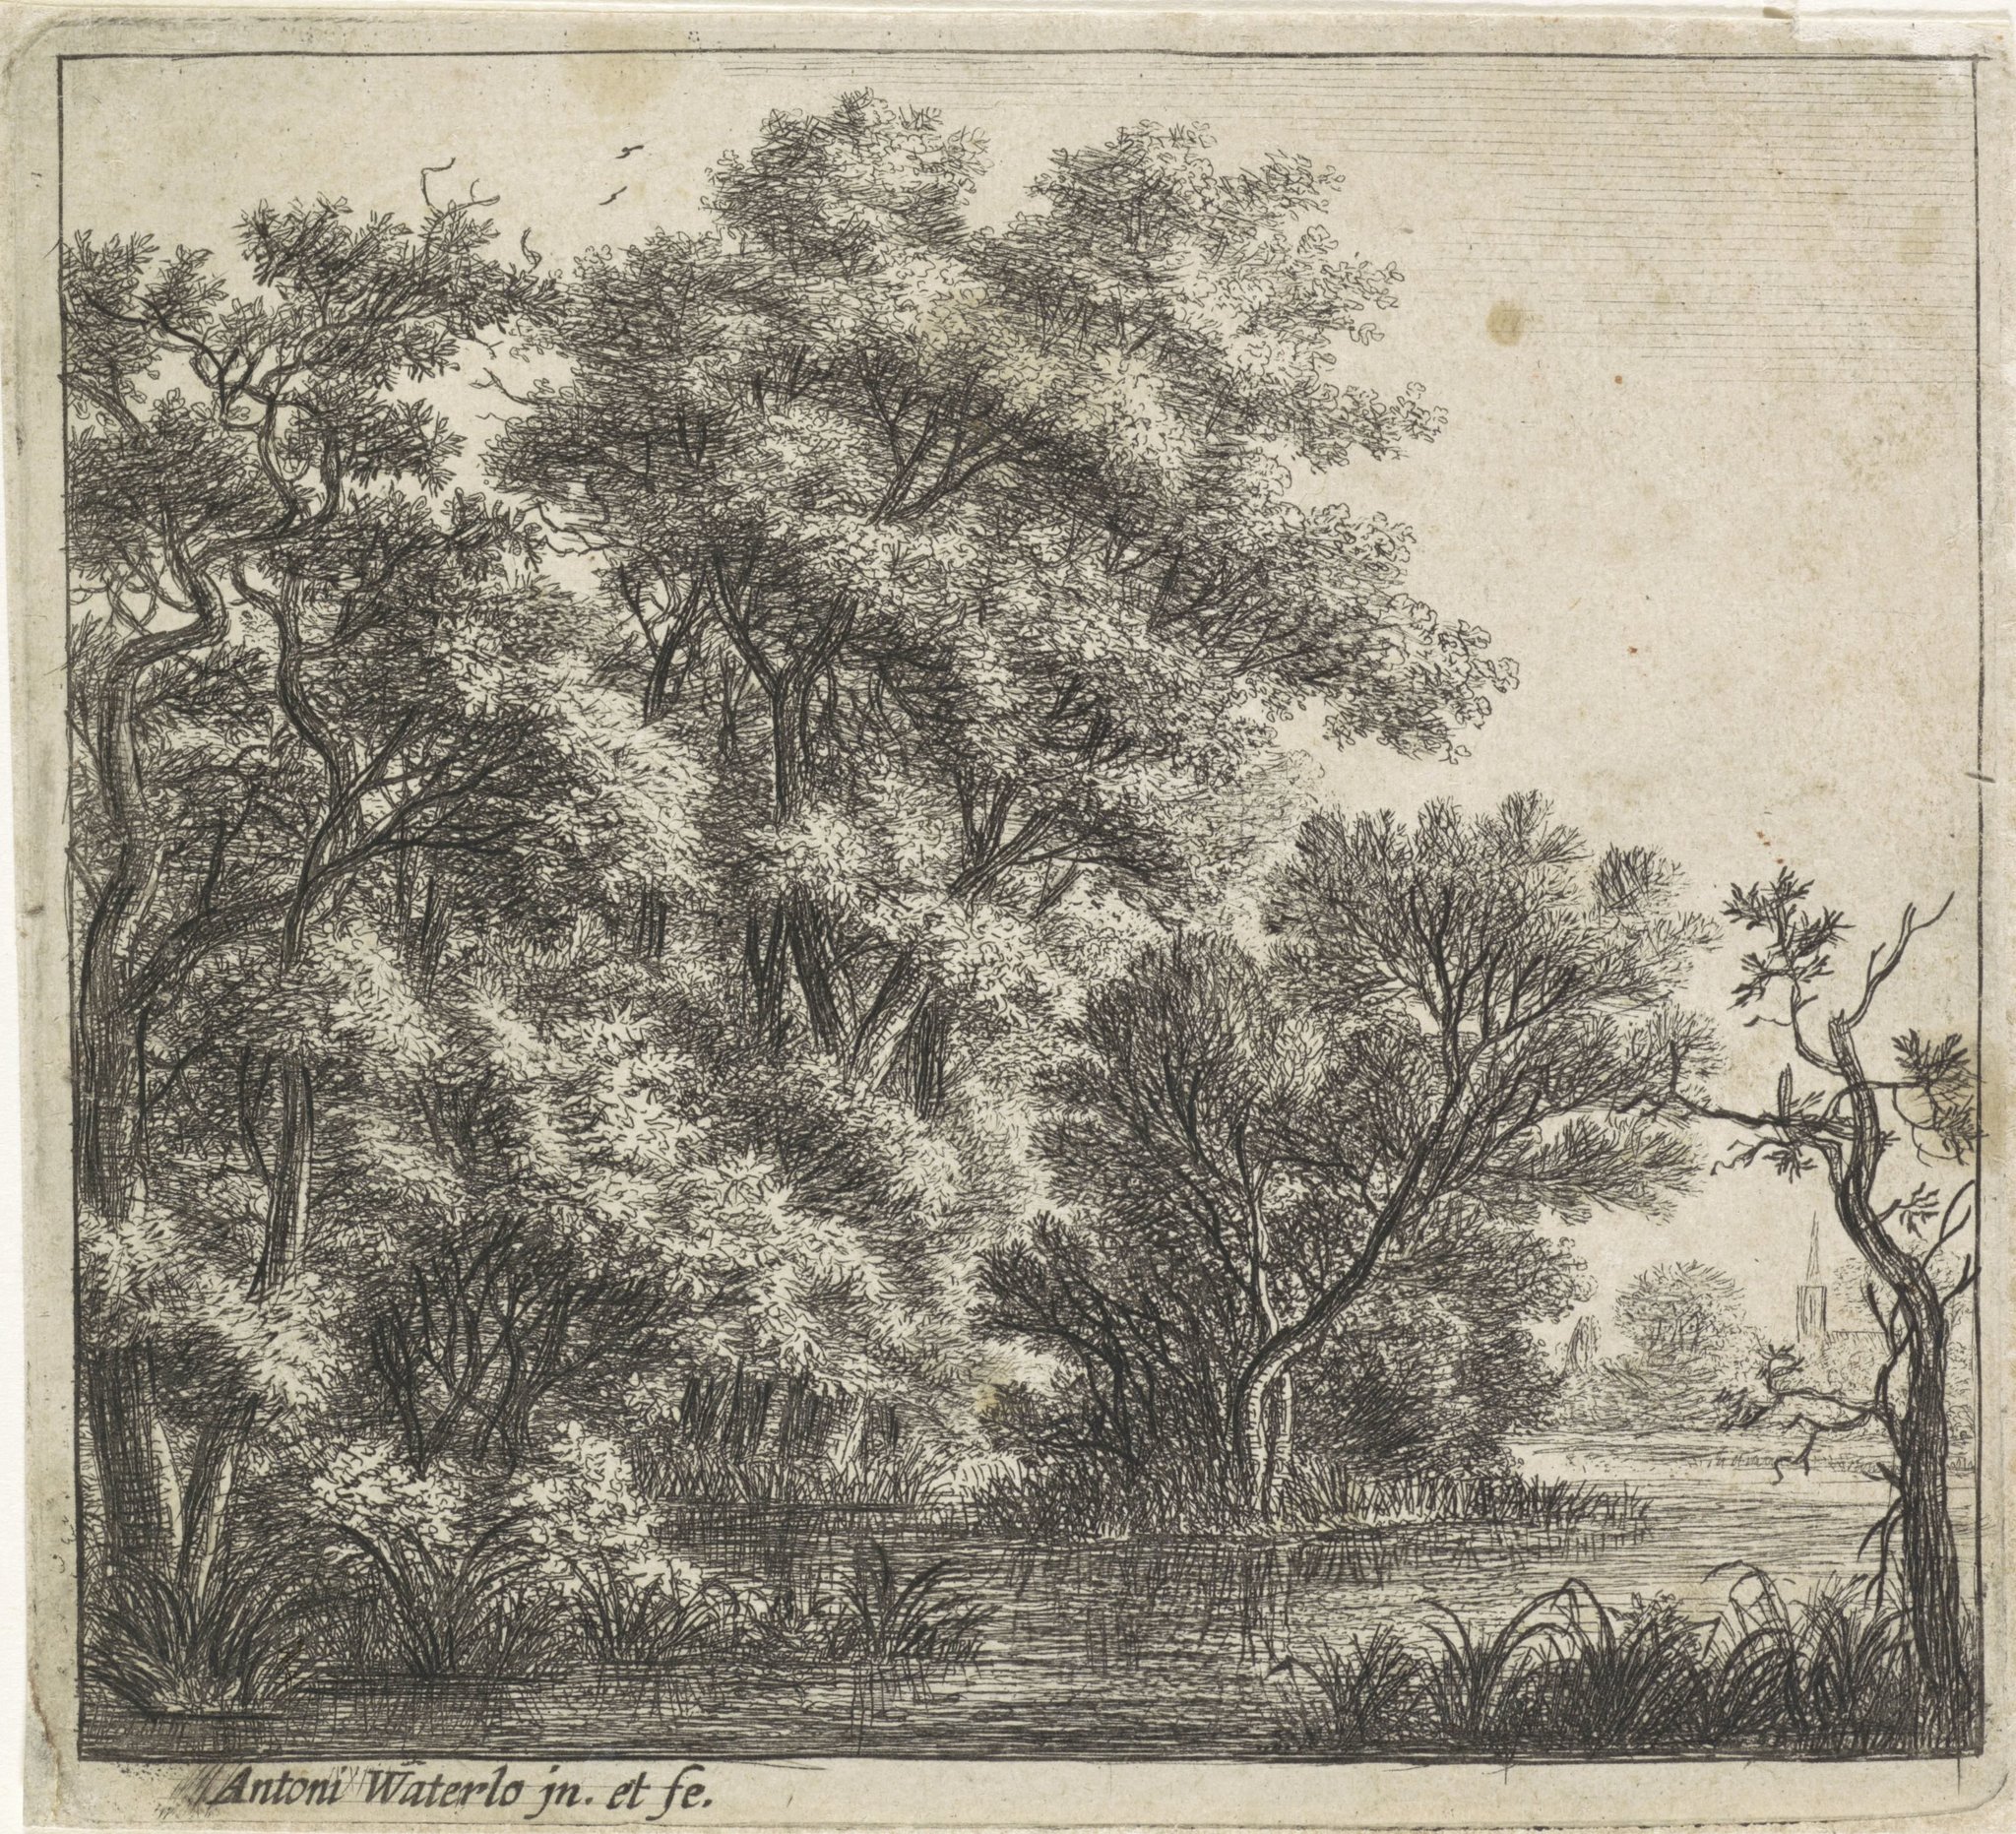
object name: print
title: Bebost eiland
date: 1630-1663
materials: paper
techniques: etching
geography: amsterdam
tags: island, church (exterior), forest, wood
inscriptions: collector's mark: Lugt 2228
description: Links is een bebost eiland te zien en rechts in de verte is een kerk weergegeven.